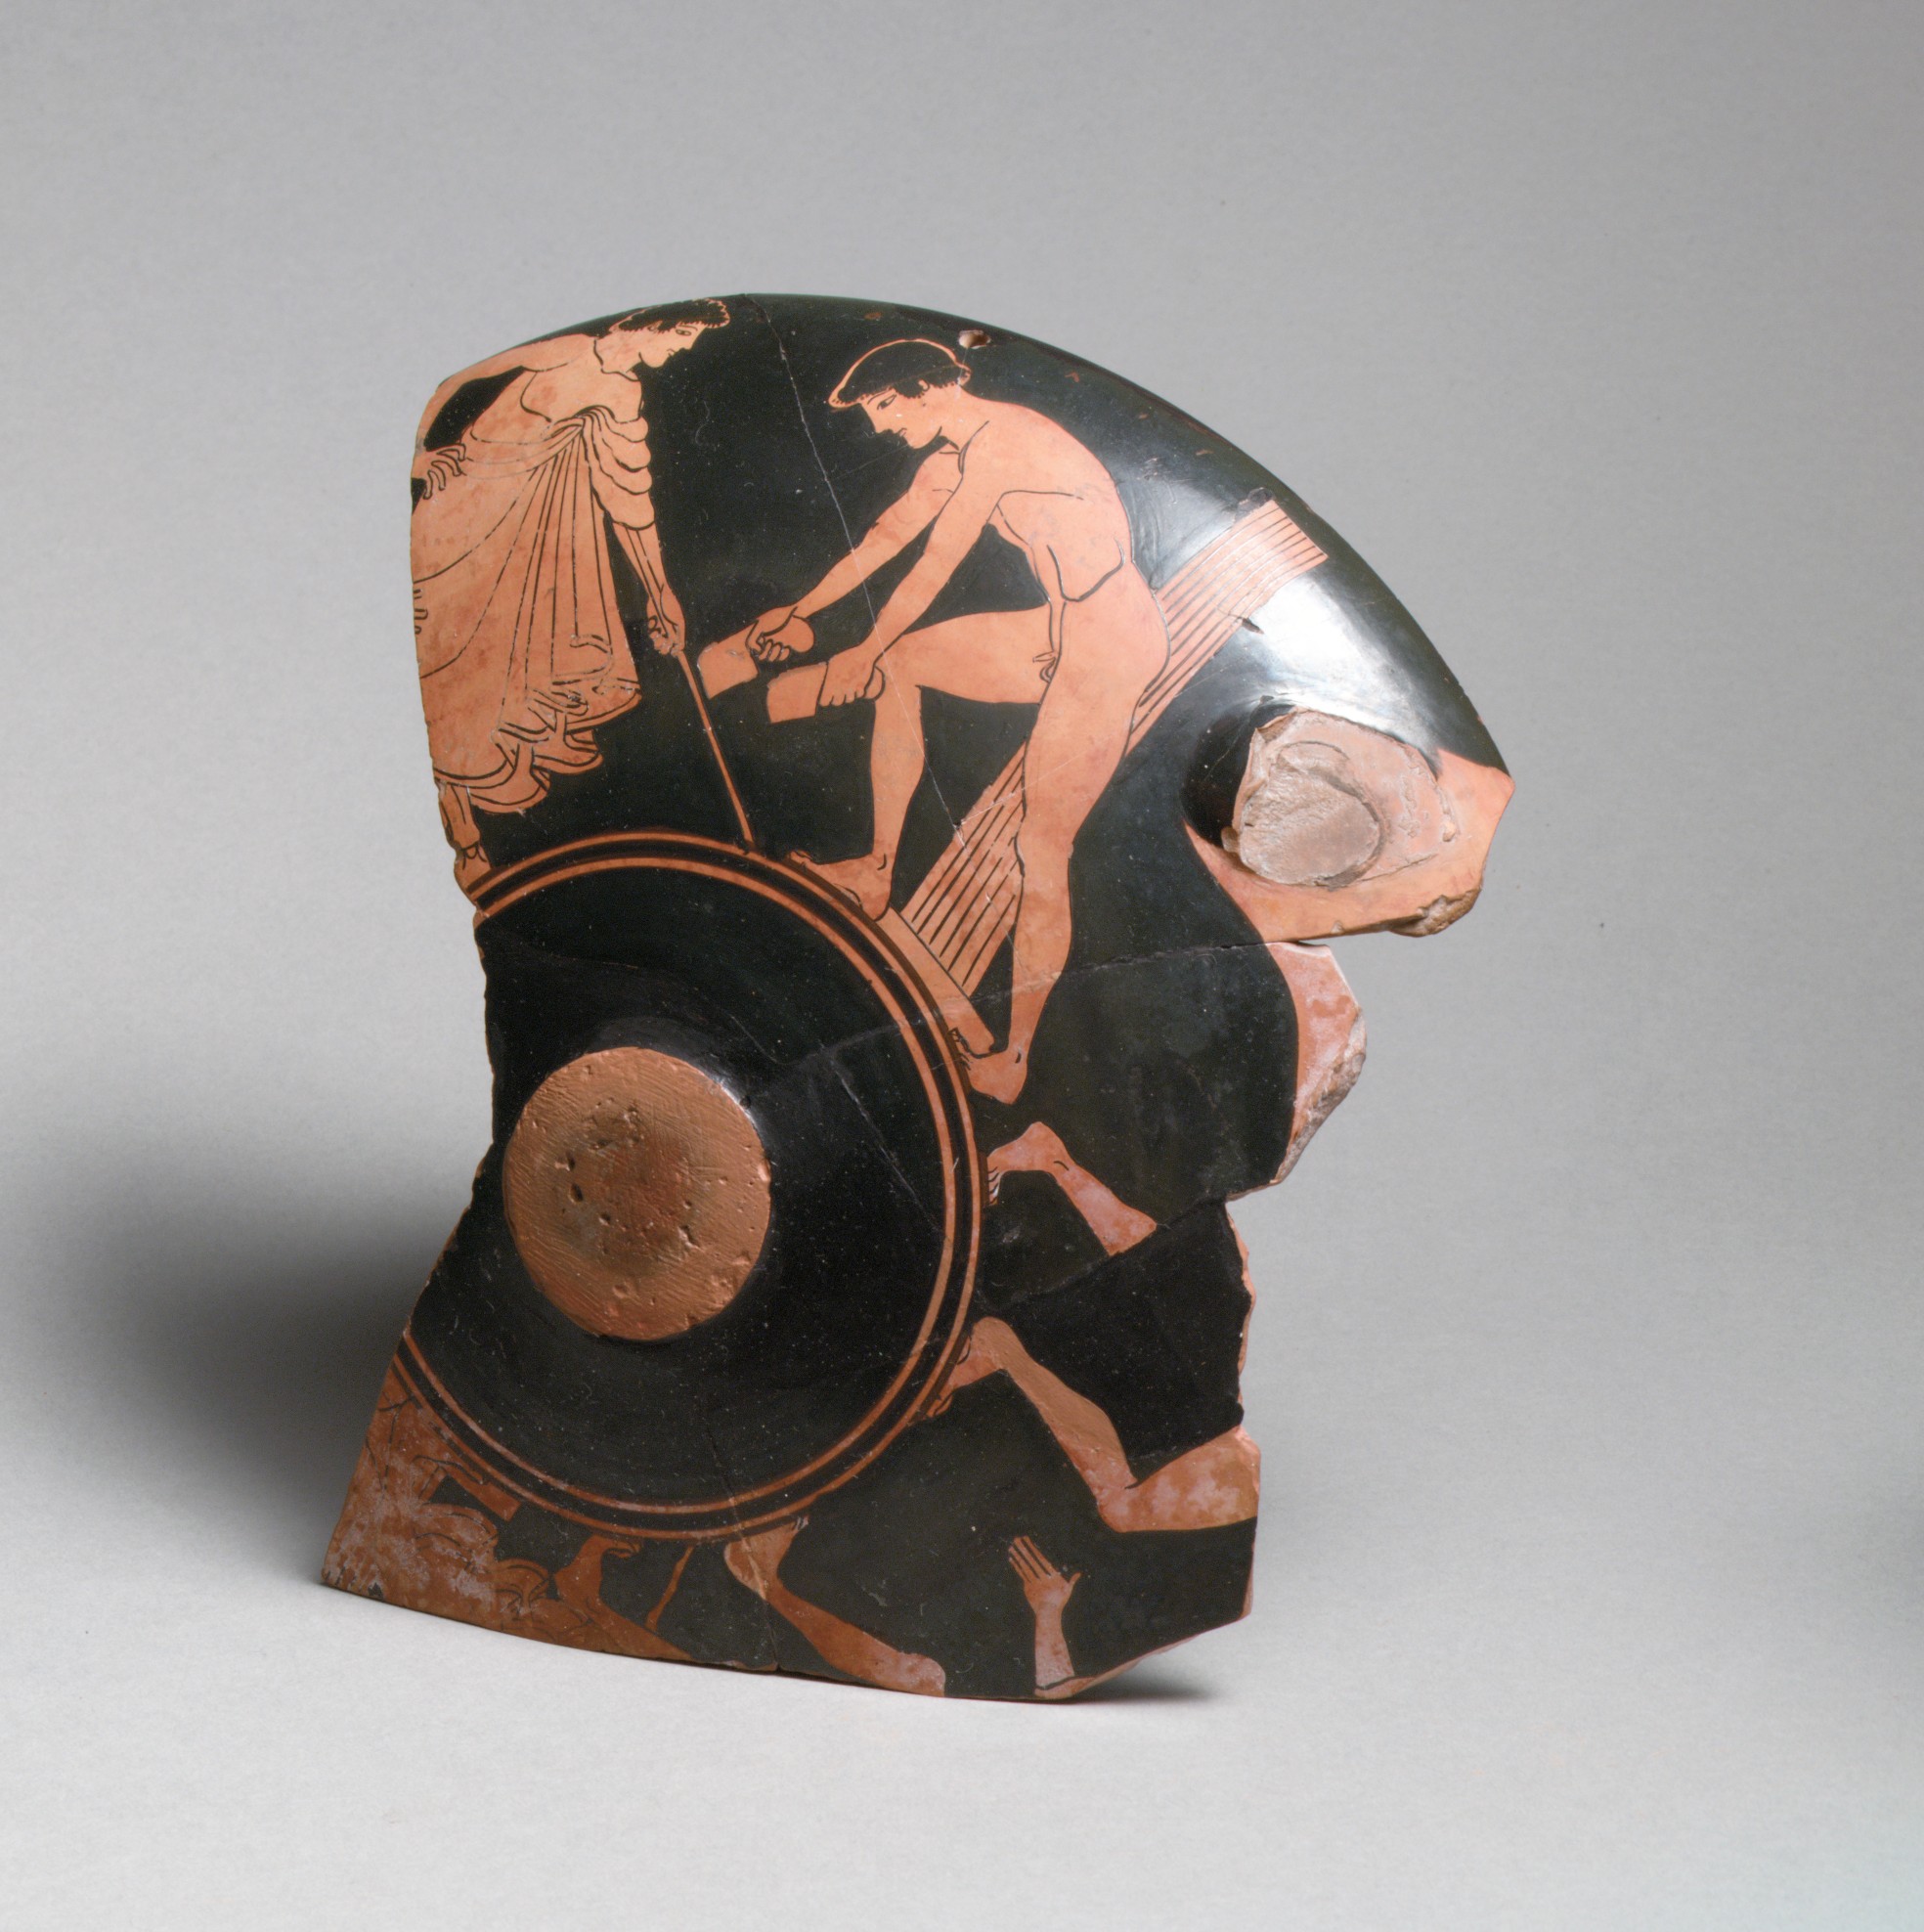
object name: kylix fragment, 6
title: Kylix fragments, 6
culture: greek, attic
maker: antiphon painter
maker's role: artist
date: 490 BCE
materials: terracotta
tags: male nudes